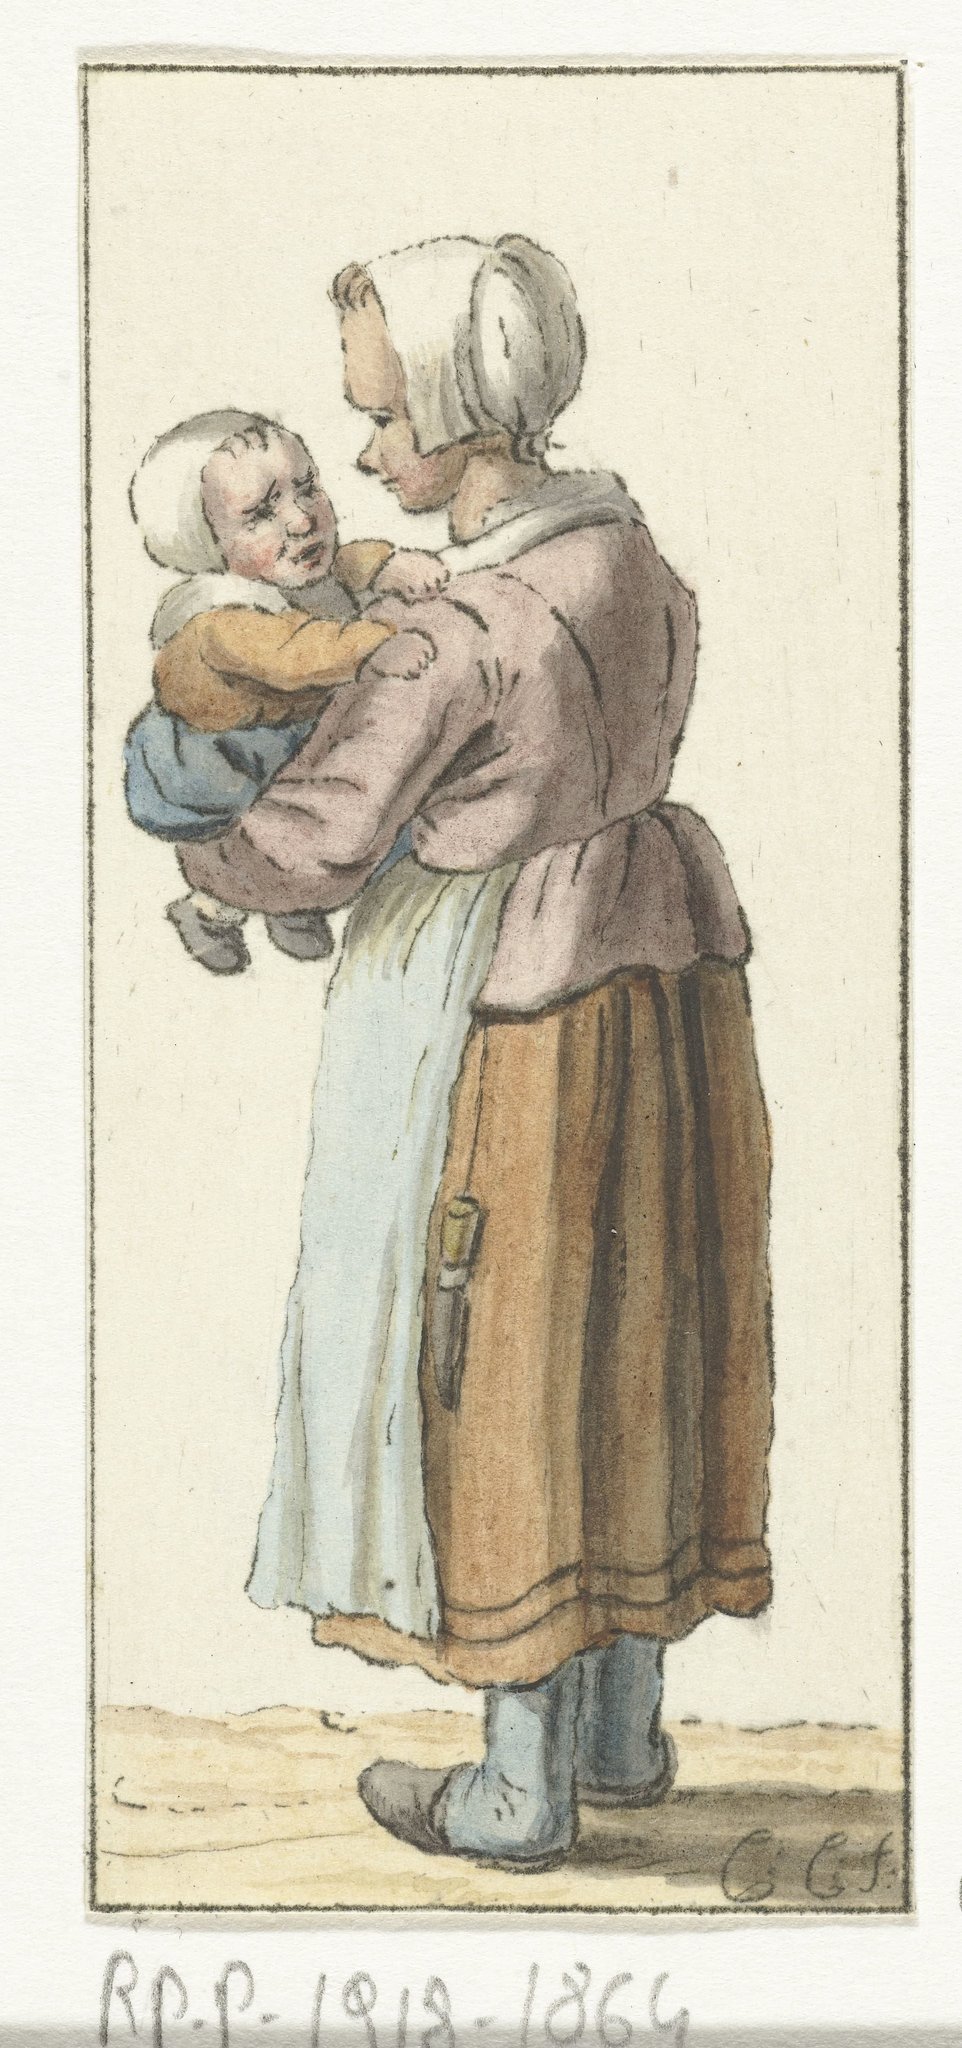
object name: print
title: Moeder met kind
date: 1779-1796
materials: paper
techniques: brush, etching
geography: leiden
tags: mother and daughter(s) (family group) (with number of daughters)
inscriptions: collector's mark: Lugt 2233